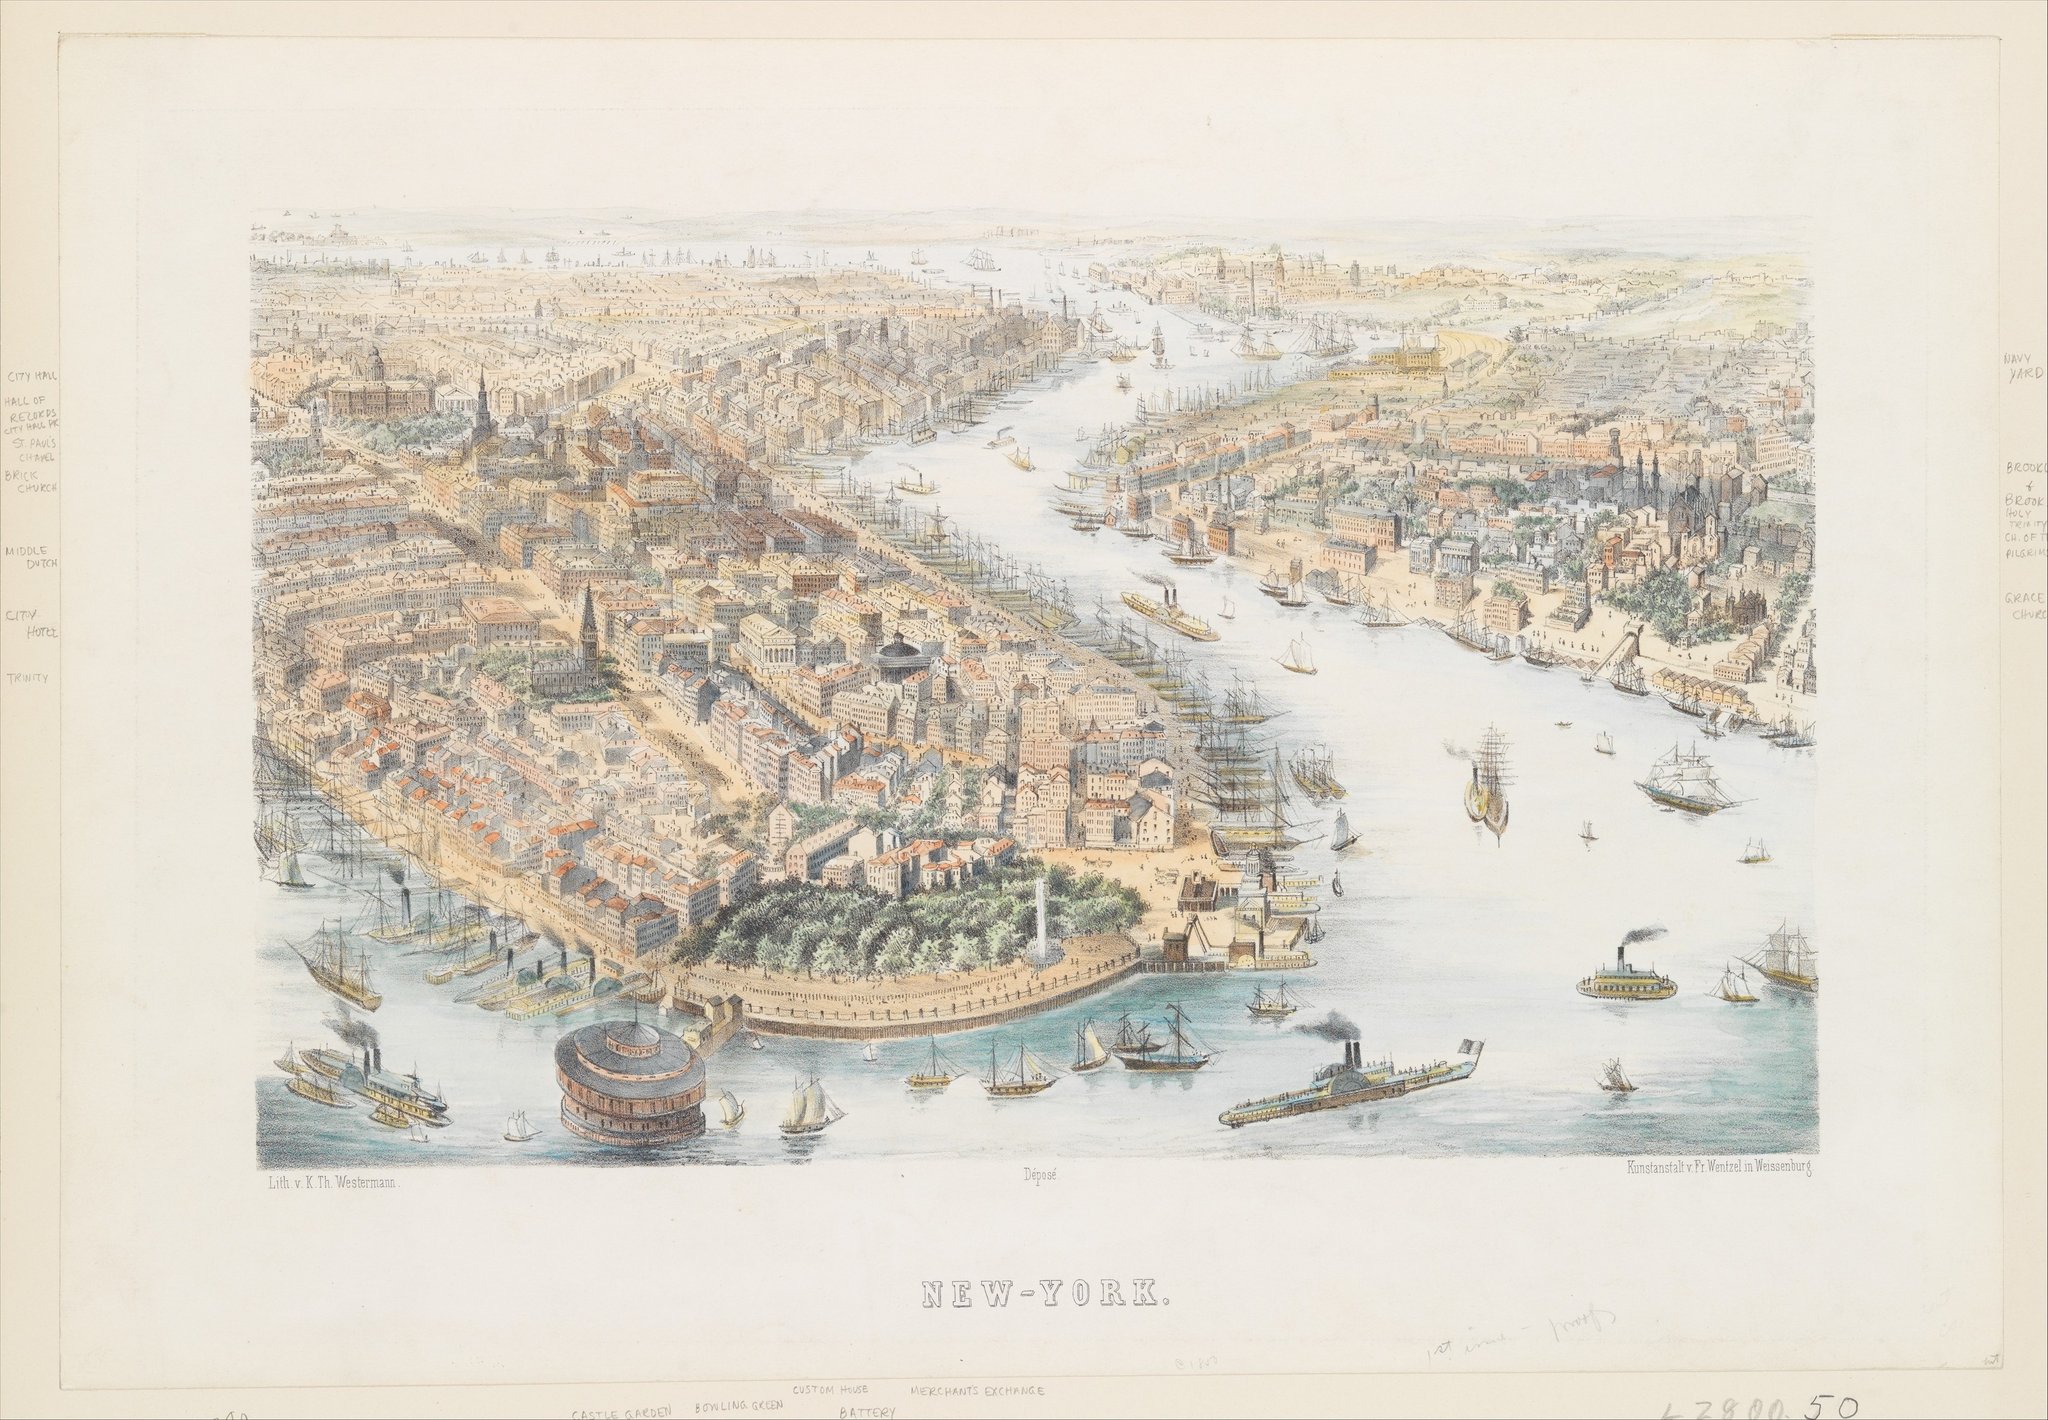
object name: print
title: New-York (From the Southwest)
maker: k. th. westermann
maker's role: lithographer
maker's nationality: german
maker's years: 1852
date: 1852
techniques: hand coloring, lithograph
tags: cities,rivers,new york city